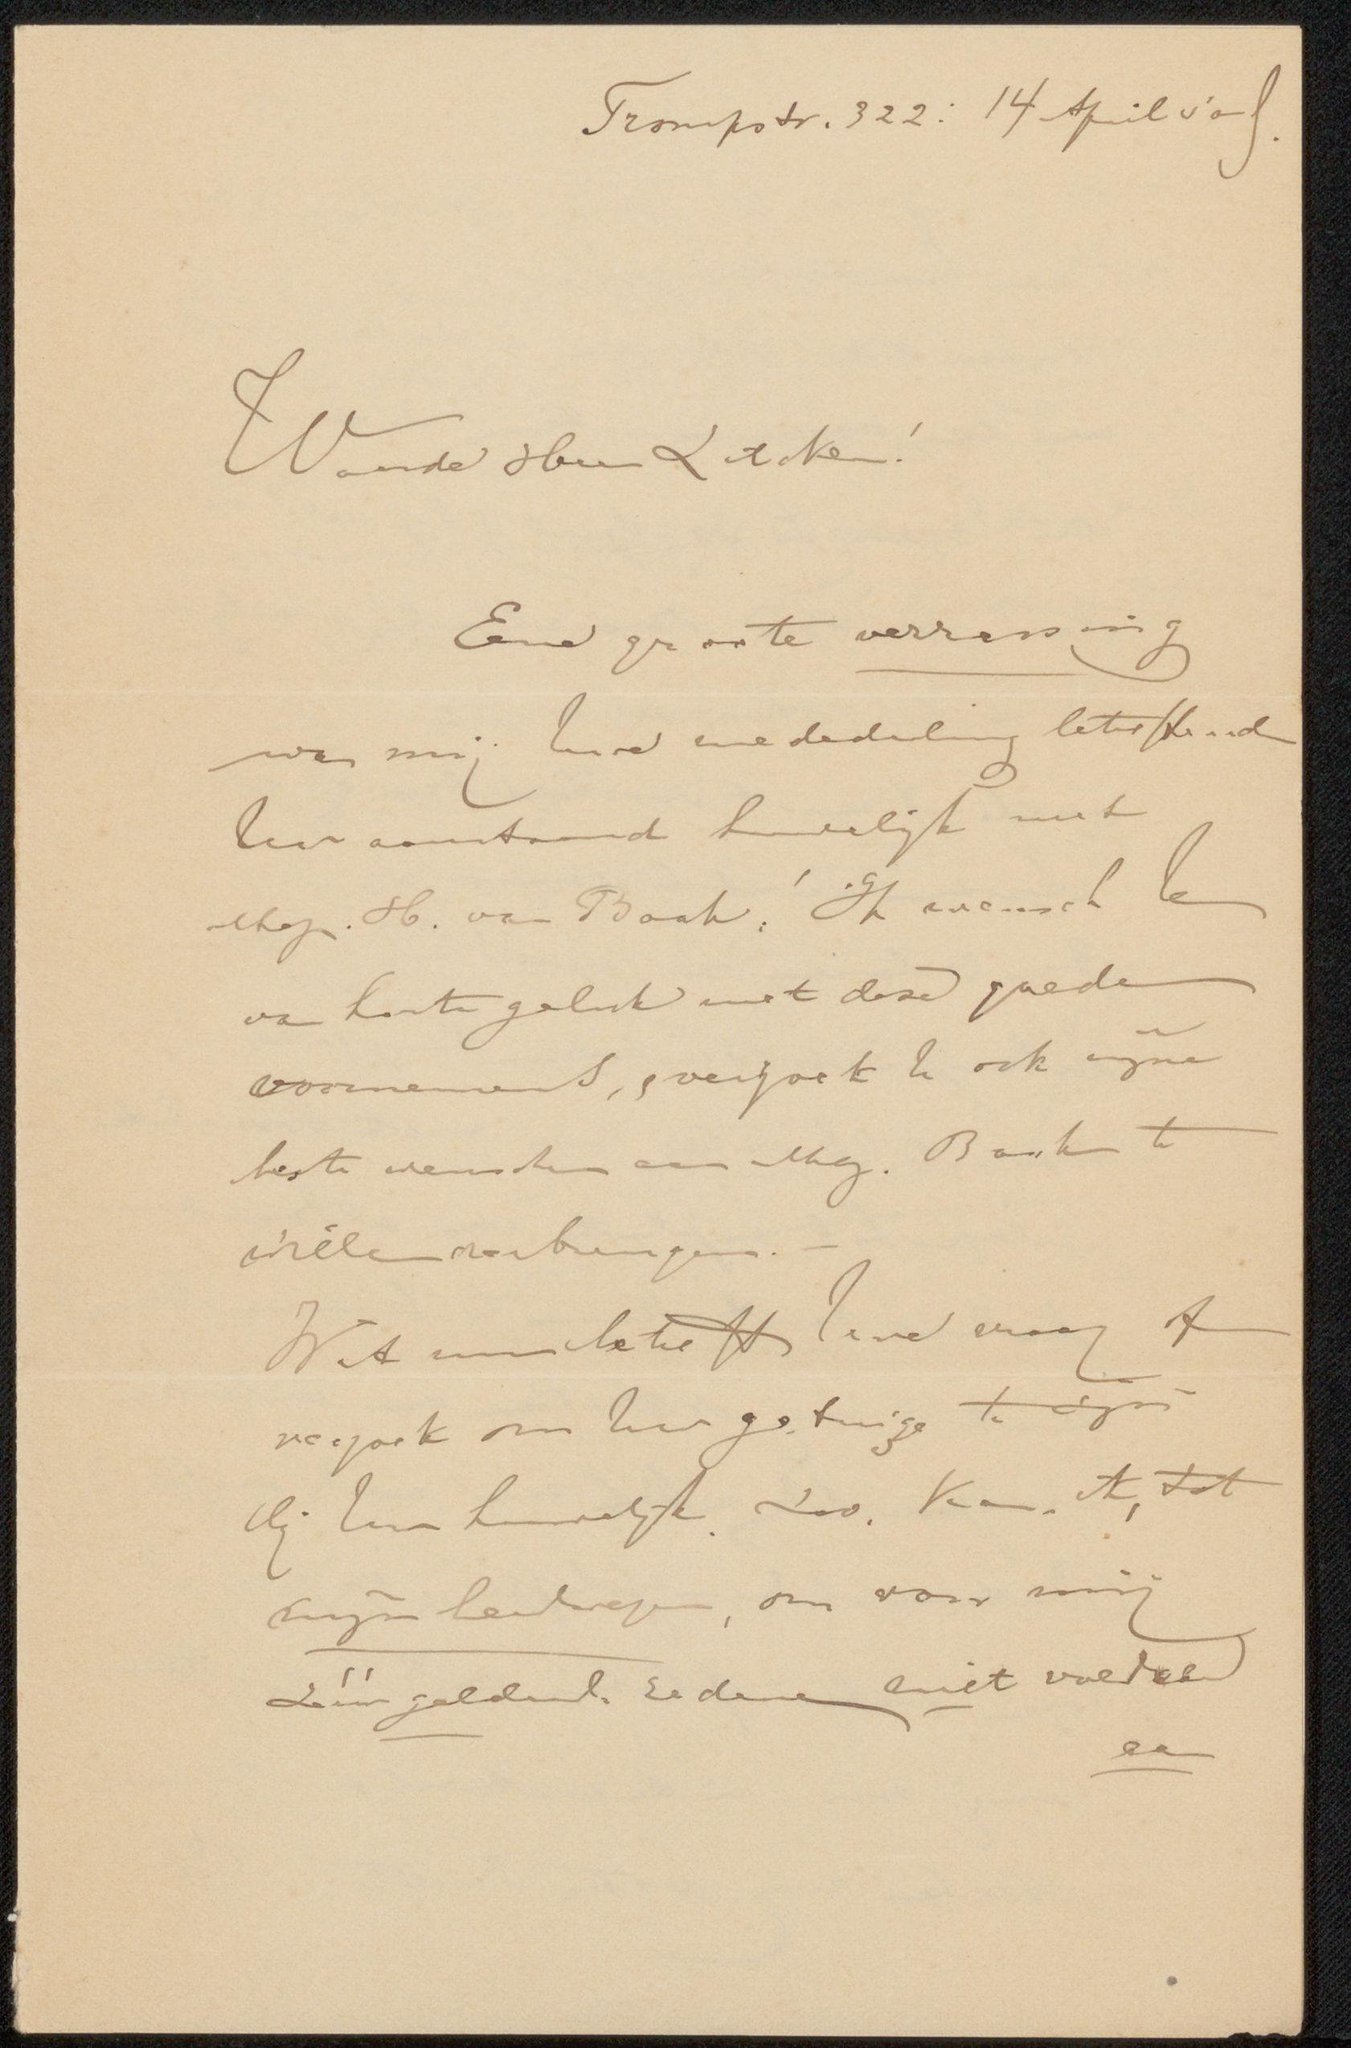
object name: letter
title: Brief aan Philip Zilcken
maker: f. von weckerlin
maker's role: schrijver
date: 1915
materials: ink, paper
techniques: pen, writing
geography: the hague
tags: henriette wilhelmina van baak, painter, draughtsman, philip zilcken, family life, diseases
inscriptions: seal, collector's mark: ‘RPK’